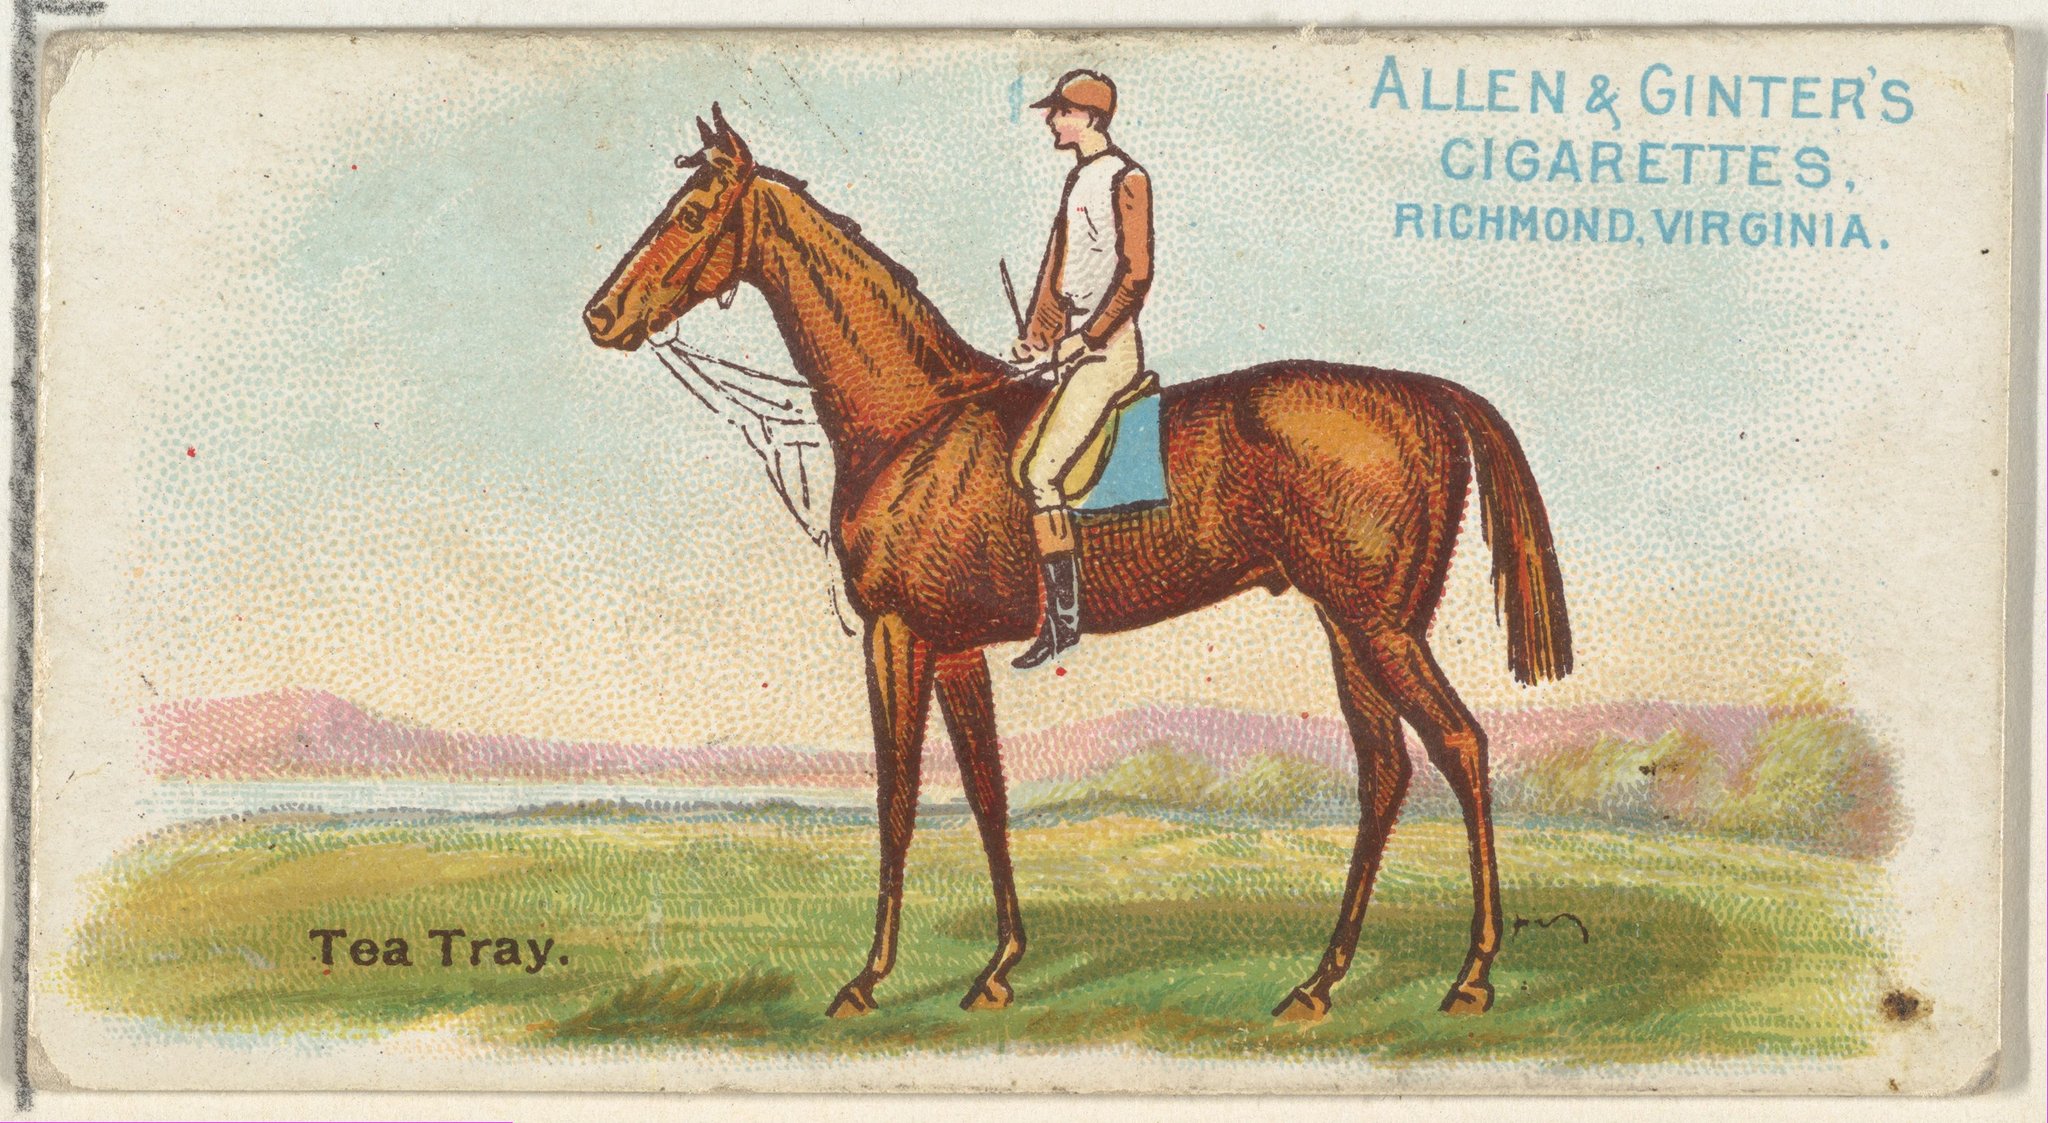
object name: print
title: Tea Tray, from The World's Racers series (N32) for Allen & Ginter Cigarettes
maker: allen & ginter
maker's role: publisher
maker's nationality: american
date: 1888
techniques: color lithograph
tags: men,horses,jockeys